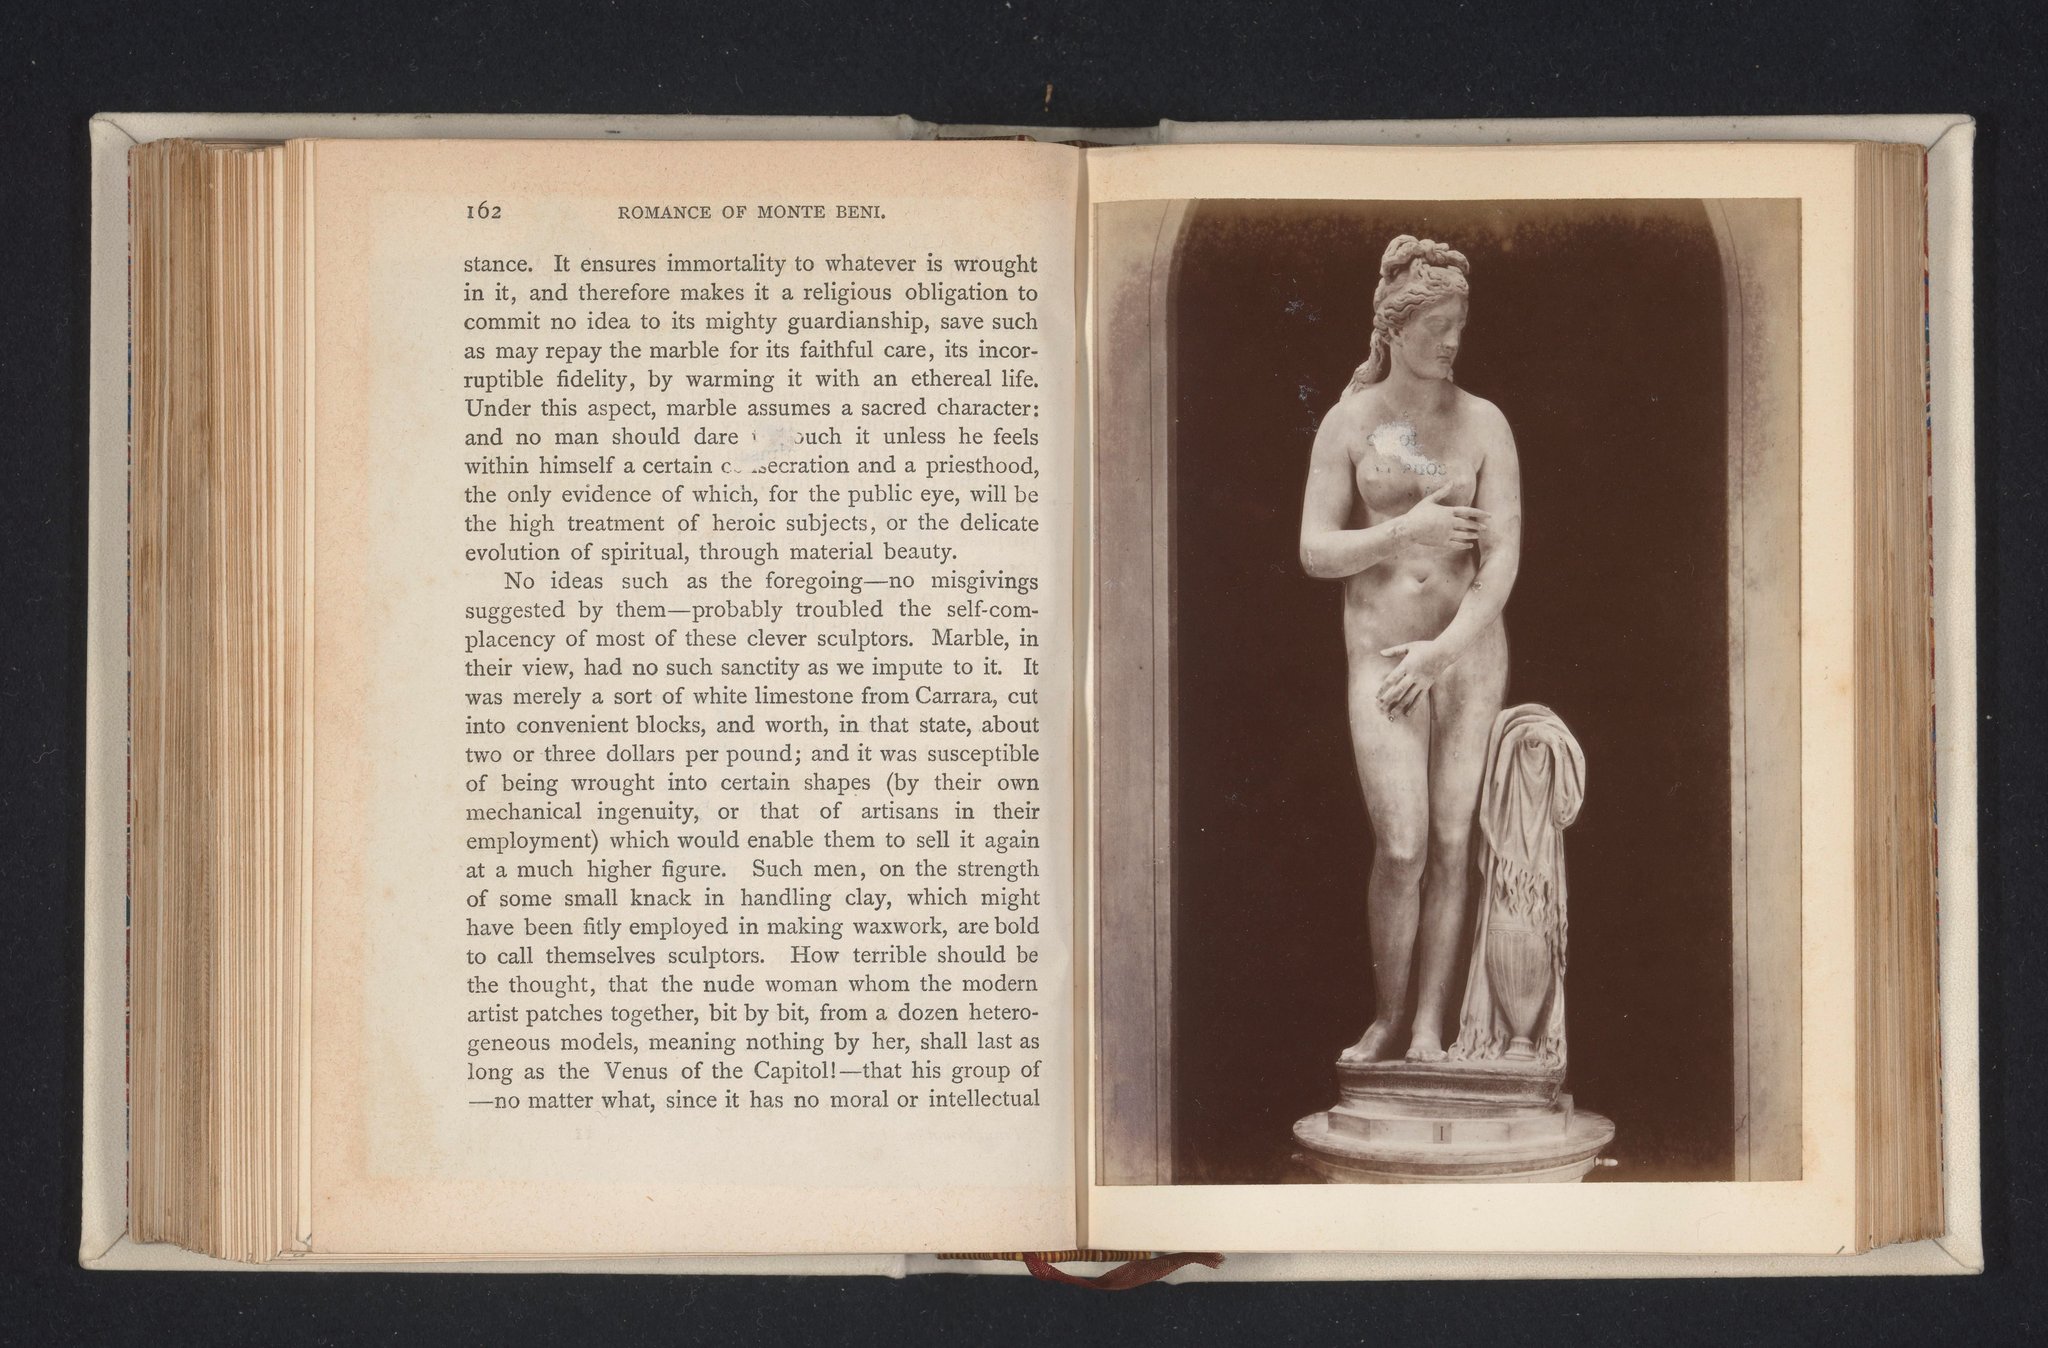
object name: page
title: Capitolijnse Venus in de Capitolijnse Musea in Rome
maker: Anonymous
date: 1850-1860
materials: photographic support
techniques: albumen print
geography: rome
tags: (story of) venus (aphrodite)